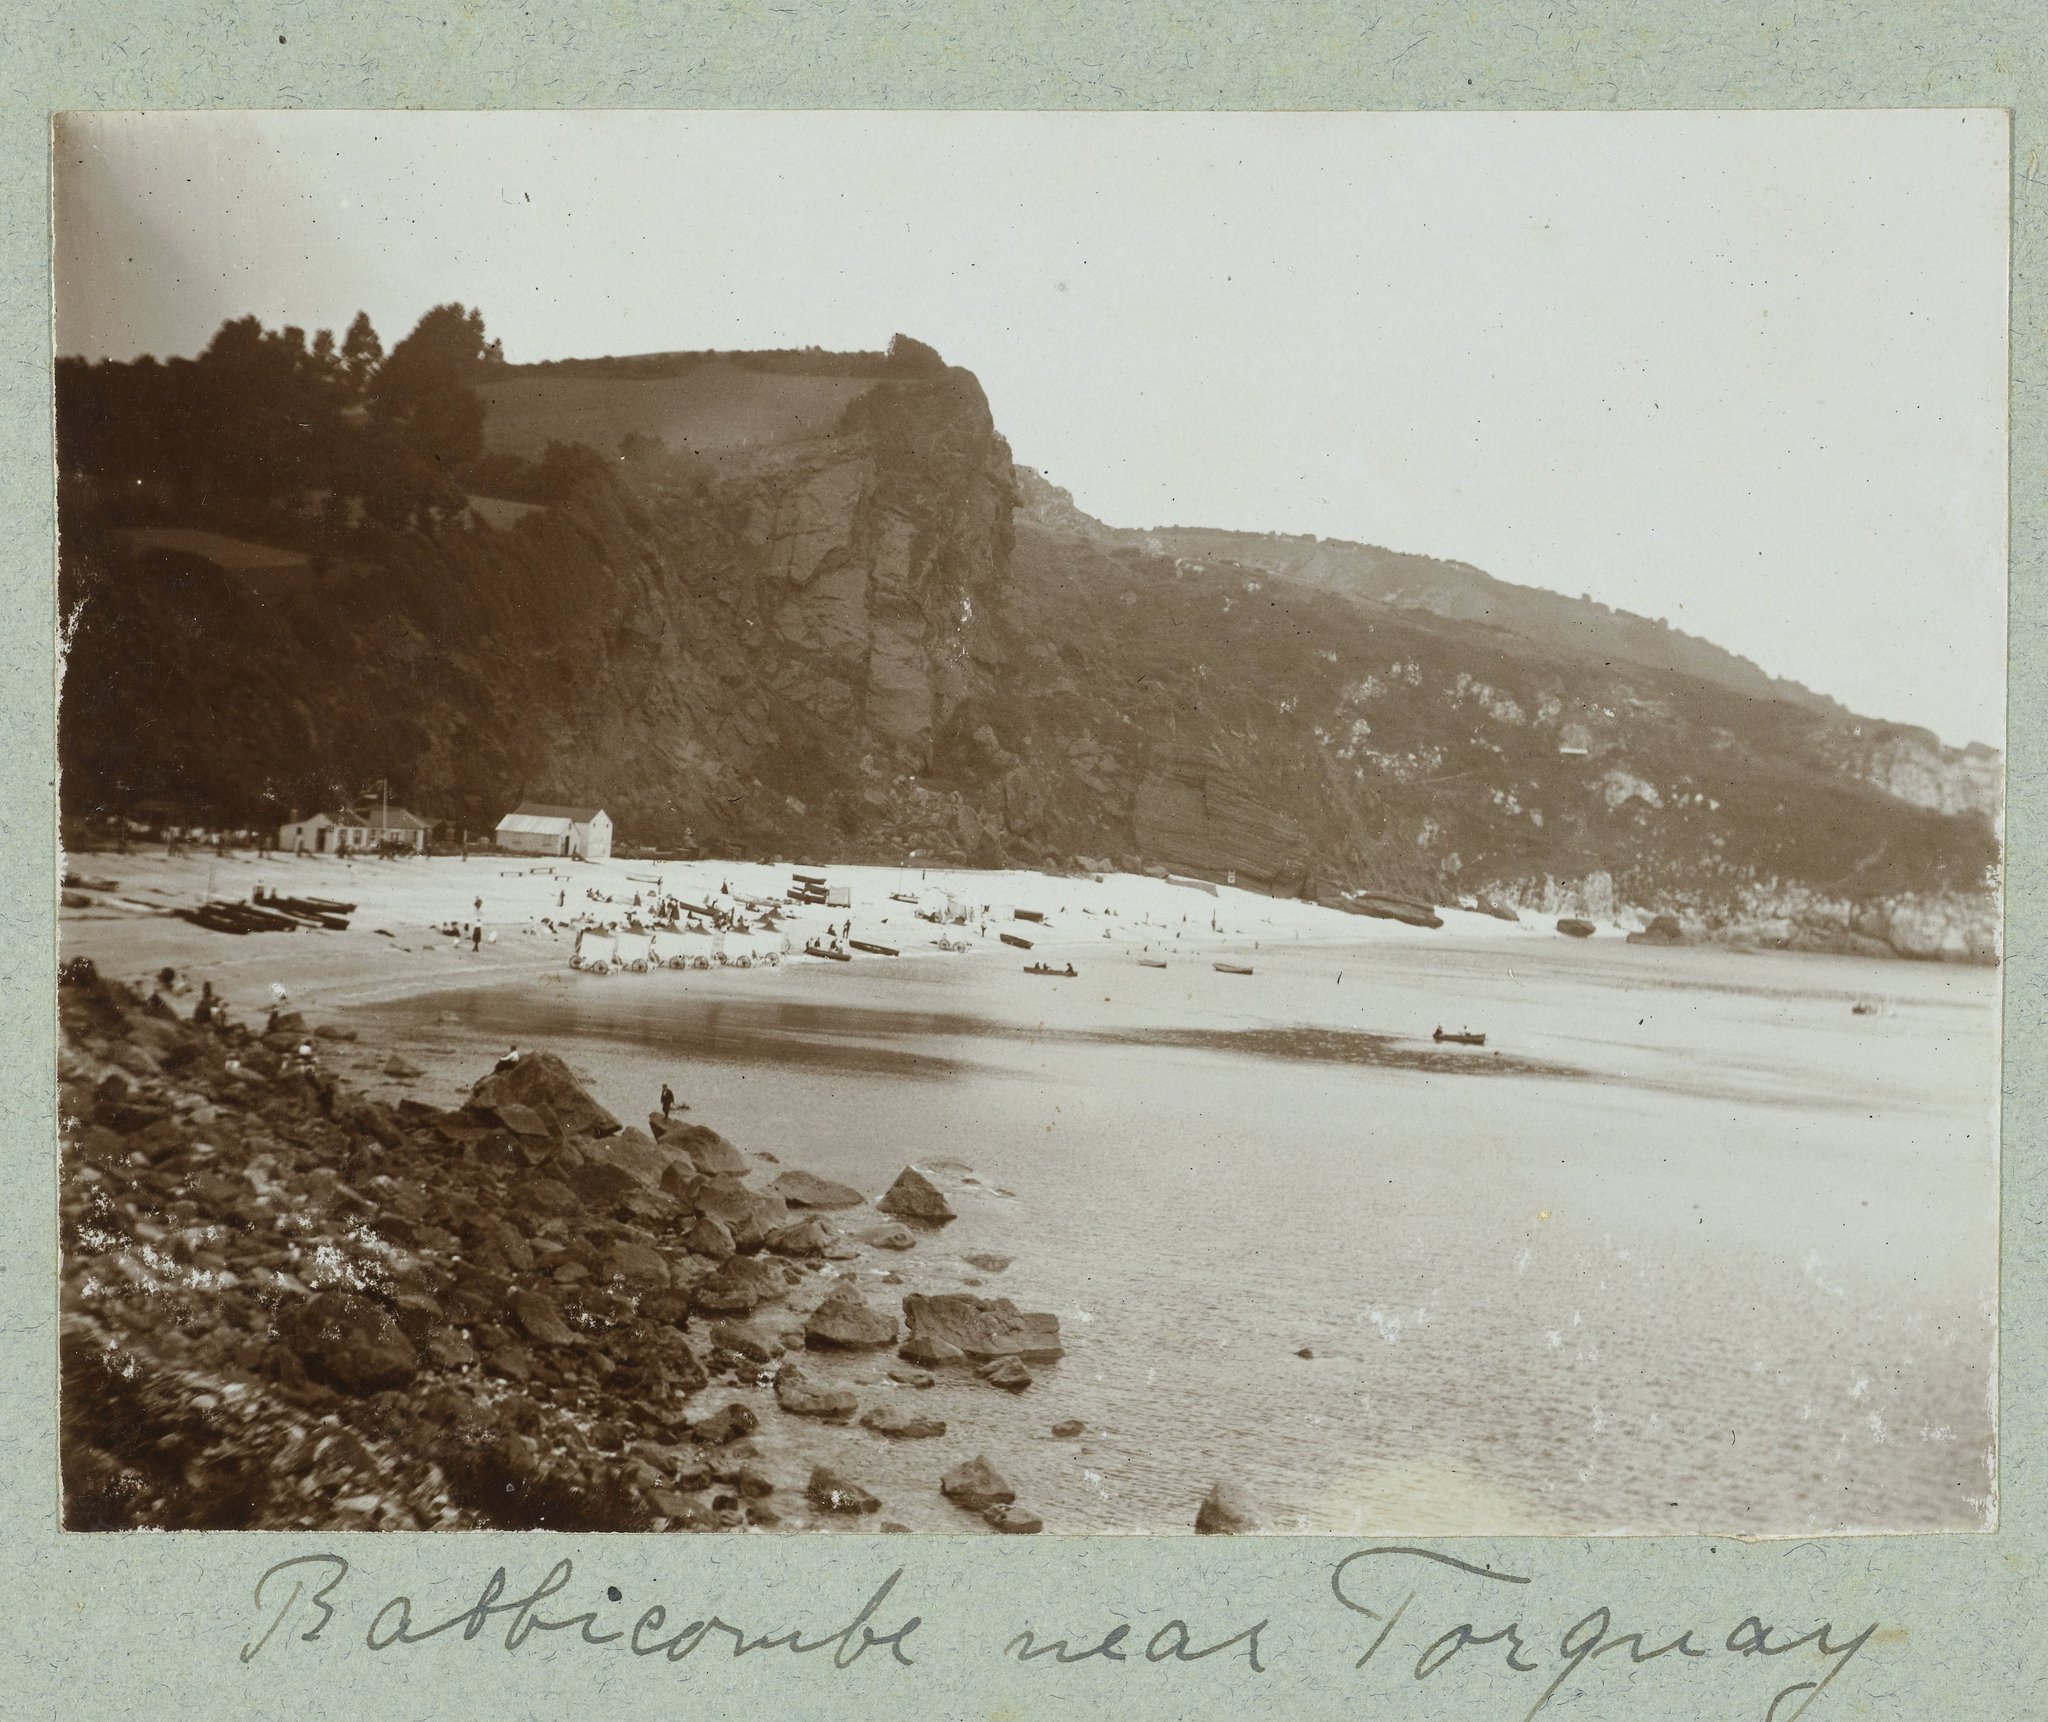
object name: photograph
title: Baai met rotsen en strand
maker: frits freerks fontein fz.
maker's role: fotograaf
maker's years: 1882-1928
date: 1901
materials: cardboard, paper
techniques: gelatin silver print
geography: england